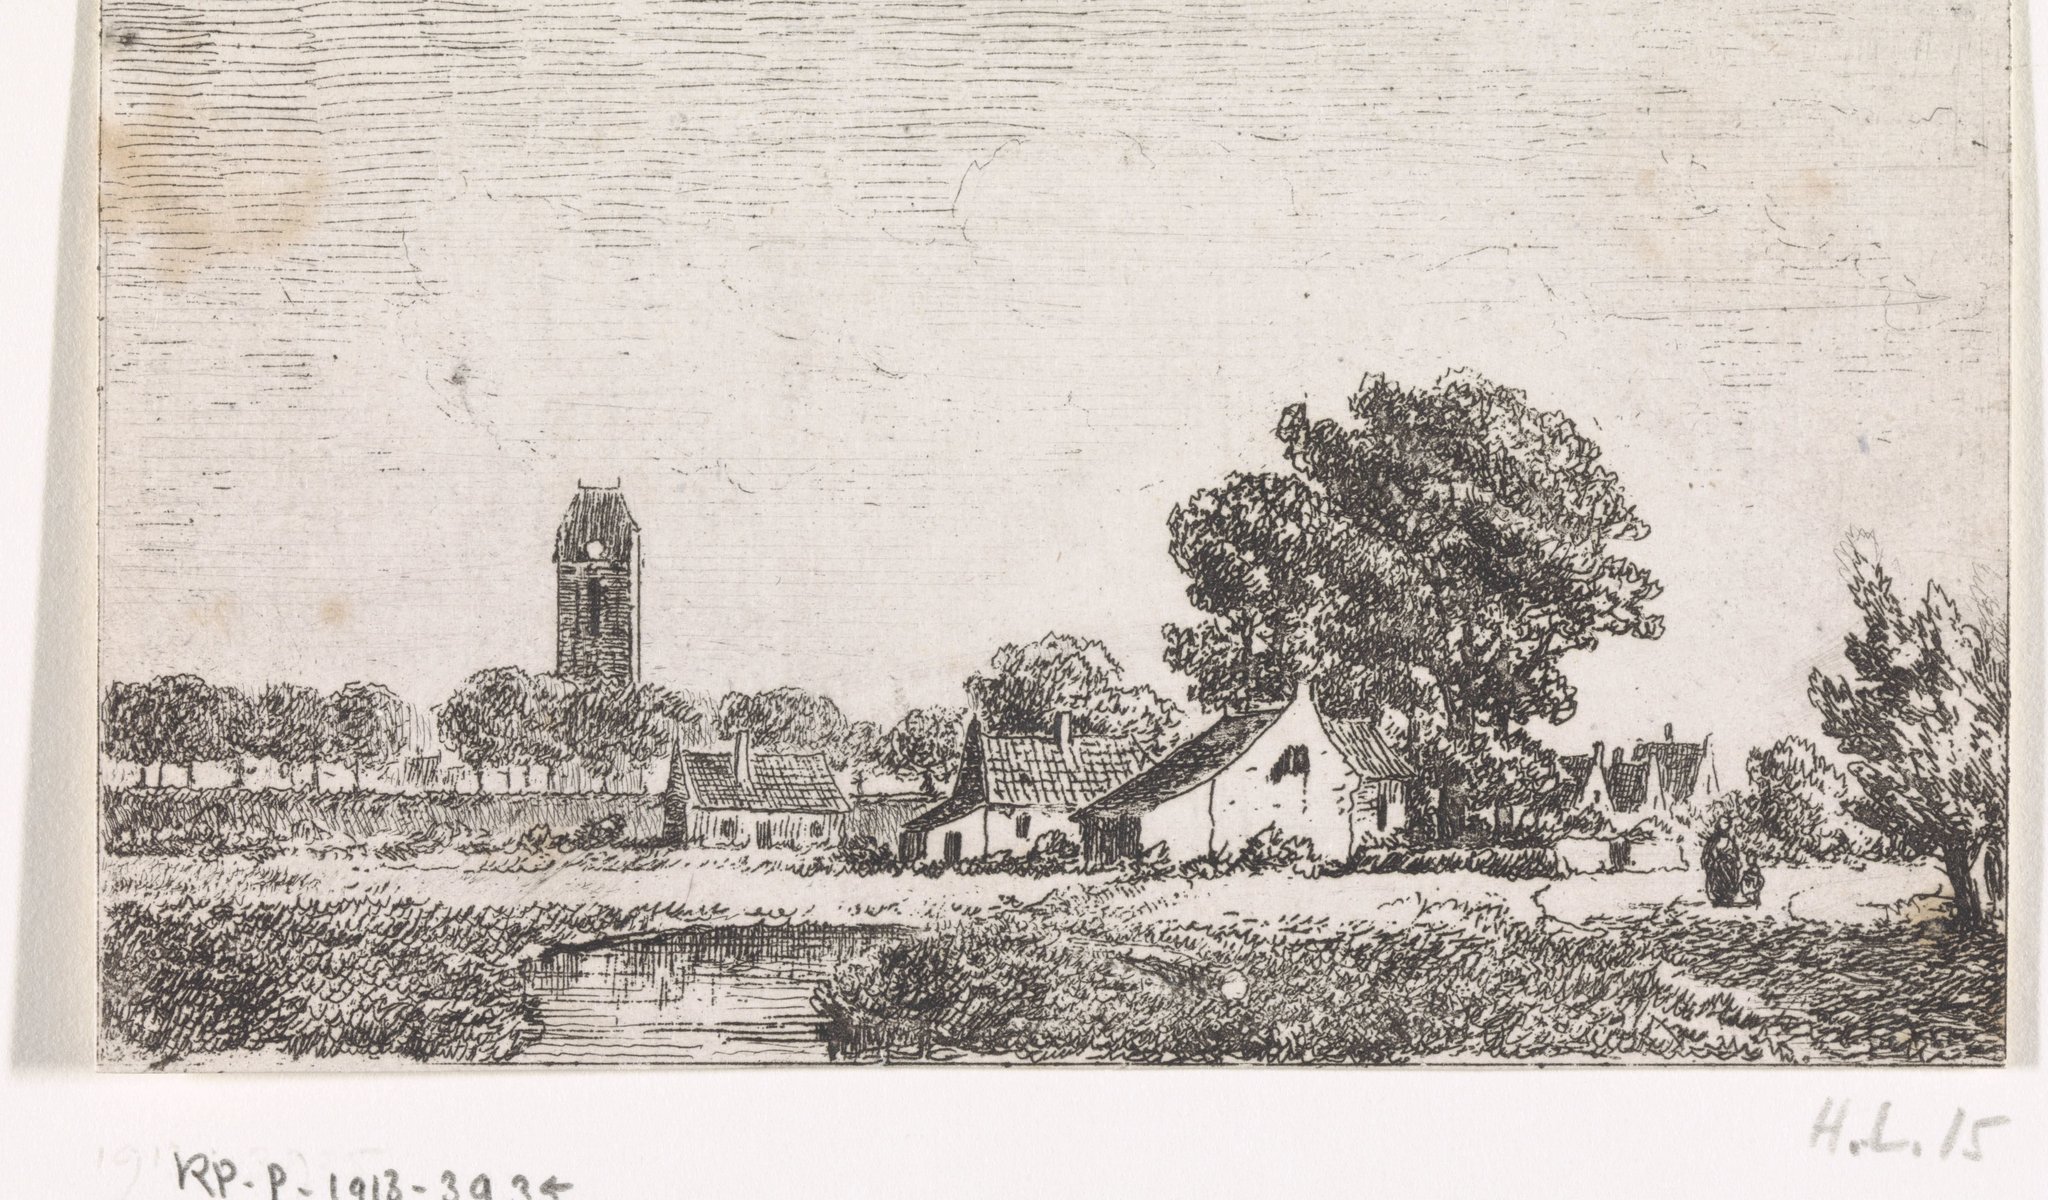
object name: print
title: Gezicht op een dorp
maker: gijsbertus johannes verspuy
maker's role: print maker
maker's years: 1823-1862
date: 1833-1862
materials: paper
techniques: etching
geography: netherlands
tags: village, dikes, levee, parts of church exterior and annexes: tower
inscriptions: collector's mark: Lugt 2228, collector's mark: Lugt 1485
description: Figuren op een pad langs huizen aan het water. Op de achtergrond een kerktoren en een dijk met bomen.